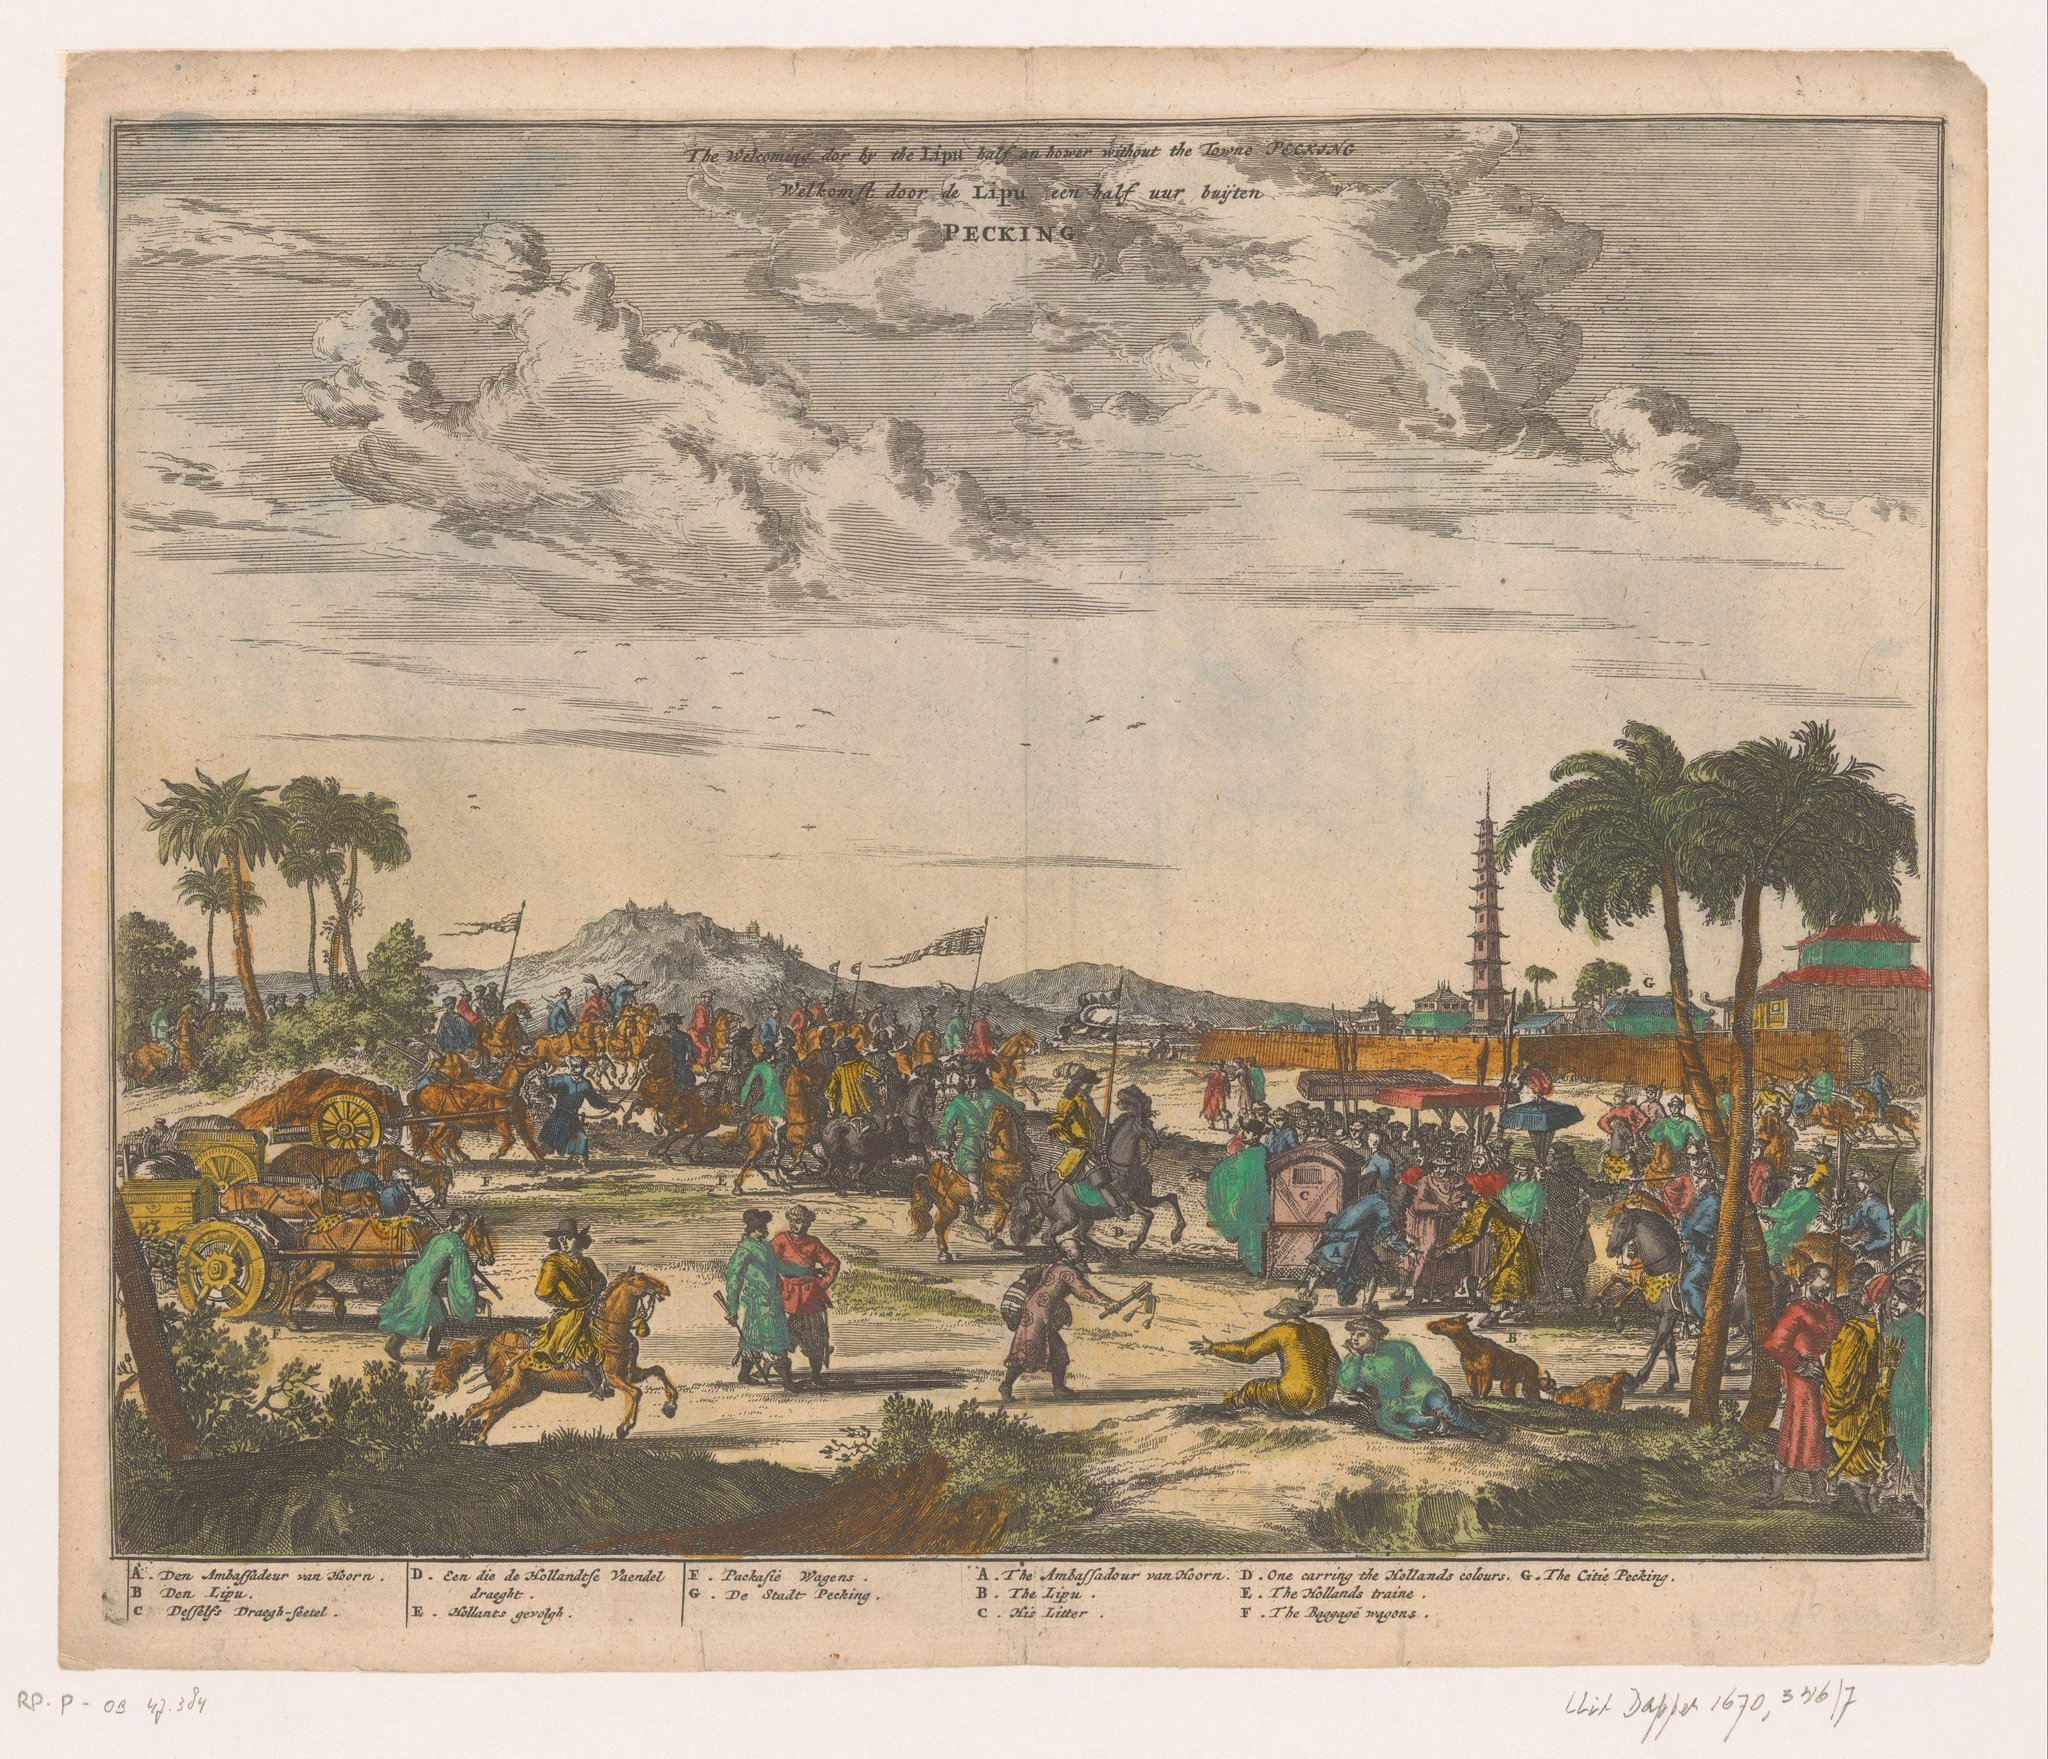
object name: book illustration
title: The Welcoming dor by the Lipu half an hower without the Towne Pecking / Welkomst door de Lipu een half uur buijten Pecking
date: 1671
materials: paper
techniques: engraving, etching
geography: london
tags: prospect of city, town panorama, silhouette of city, reception ~ ambassador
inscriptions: collector's mark: Lugt 2228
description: Met de stad Peking (Beijing) op de achtergrond wordt de Nederlandse ambassadeur met zijn gevolg ontvangen door een Chinese diplomaat. Onder de afbeelding een legenda in het Engels en Nederlands.